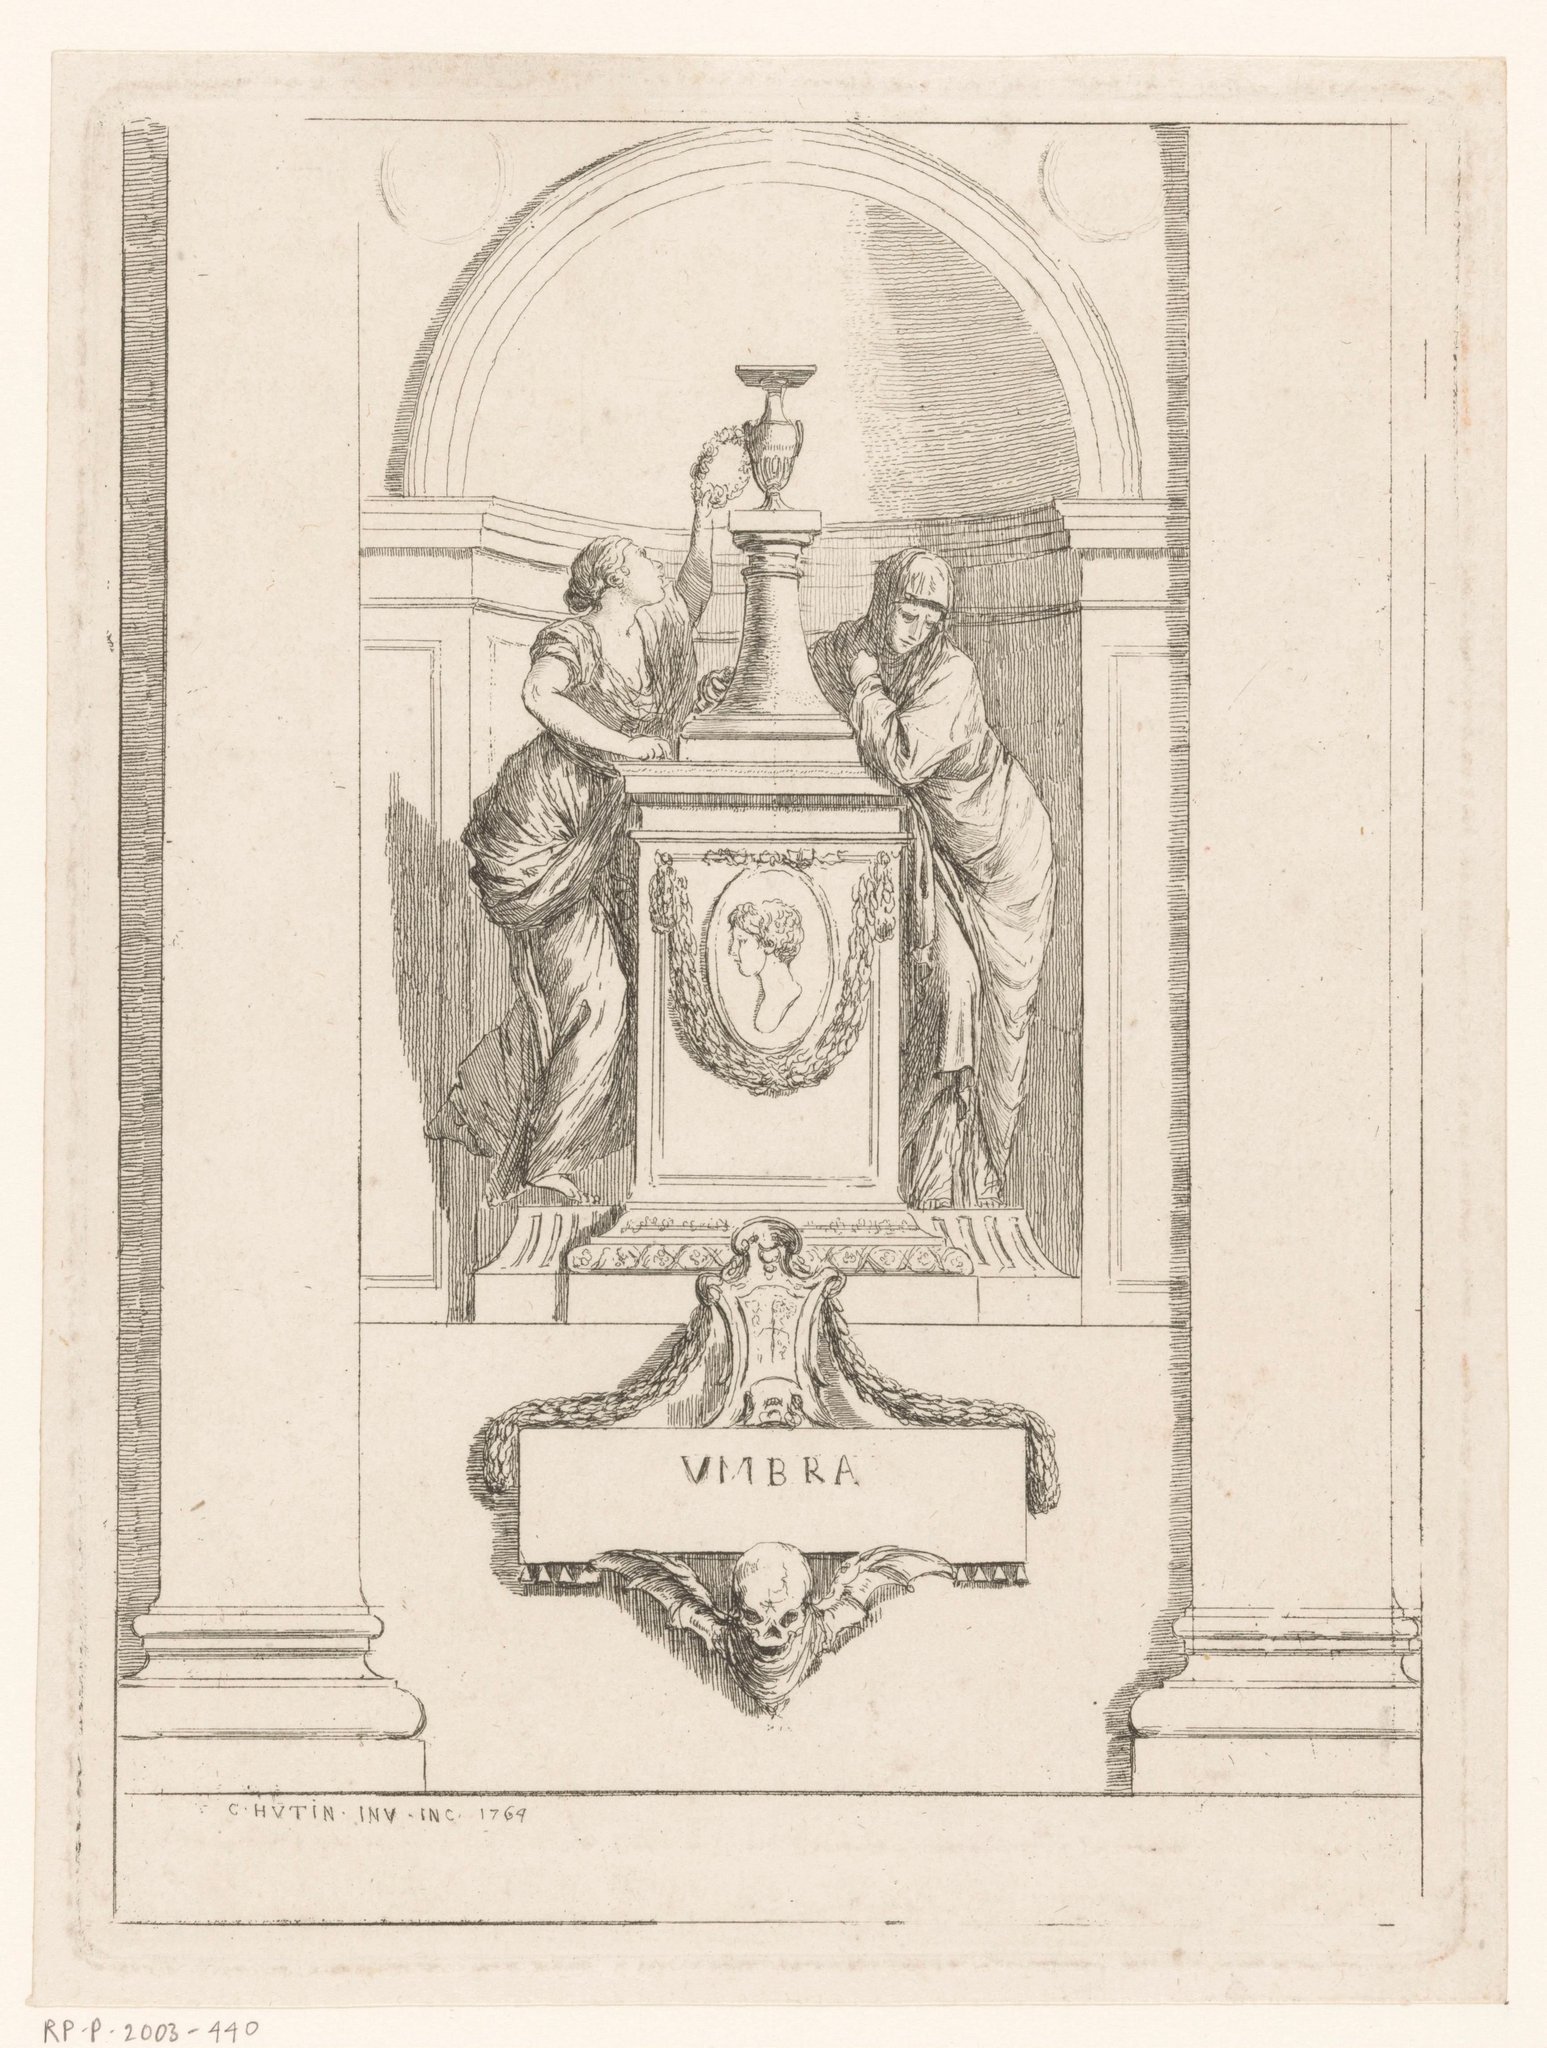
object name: print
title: Grafmonument met twee vrouwen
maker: charles françois hutin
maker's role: draughtsman, print maker, sculptor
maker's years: 1715-1776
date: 1764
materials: paper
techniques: etching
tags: grave, tomb, standing figure - aa - female human figure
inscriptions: collector's mark: Lugt 2228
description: Grafmonument in een nis geflankeerd door twee staande vrouwen. Op de top van het monument staat een urn, waaromheen de linker vrouw een bloemenkrans legt. Onderaan in een cartouche: UMBRA.